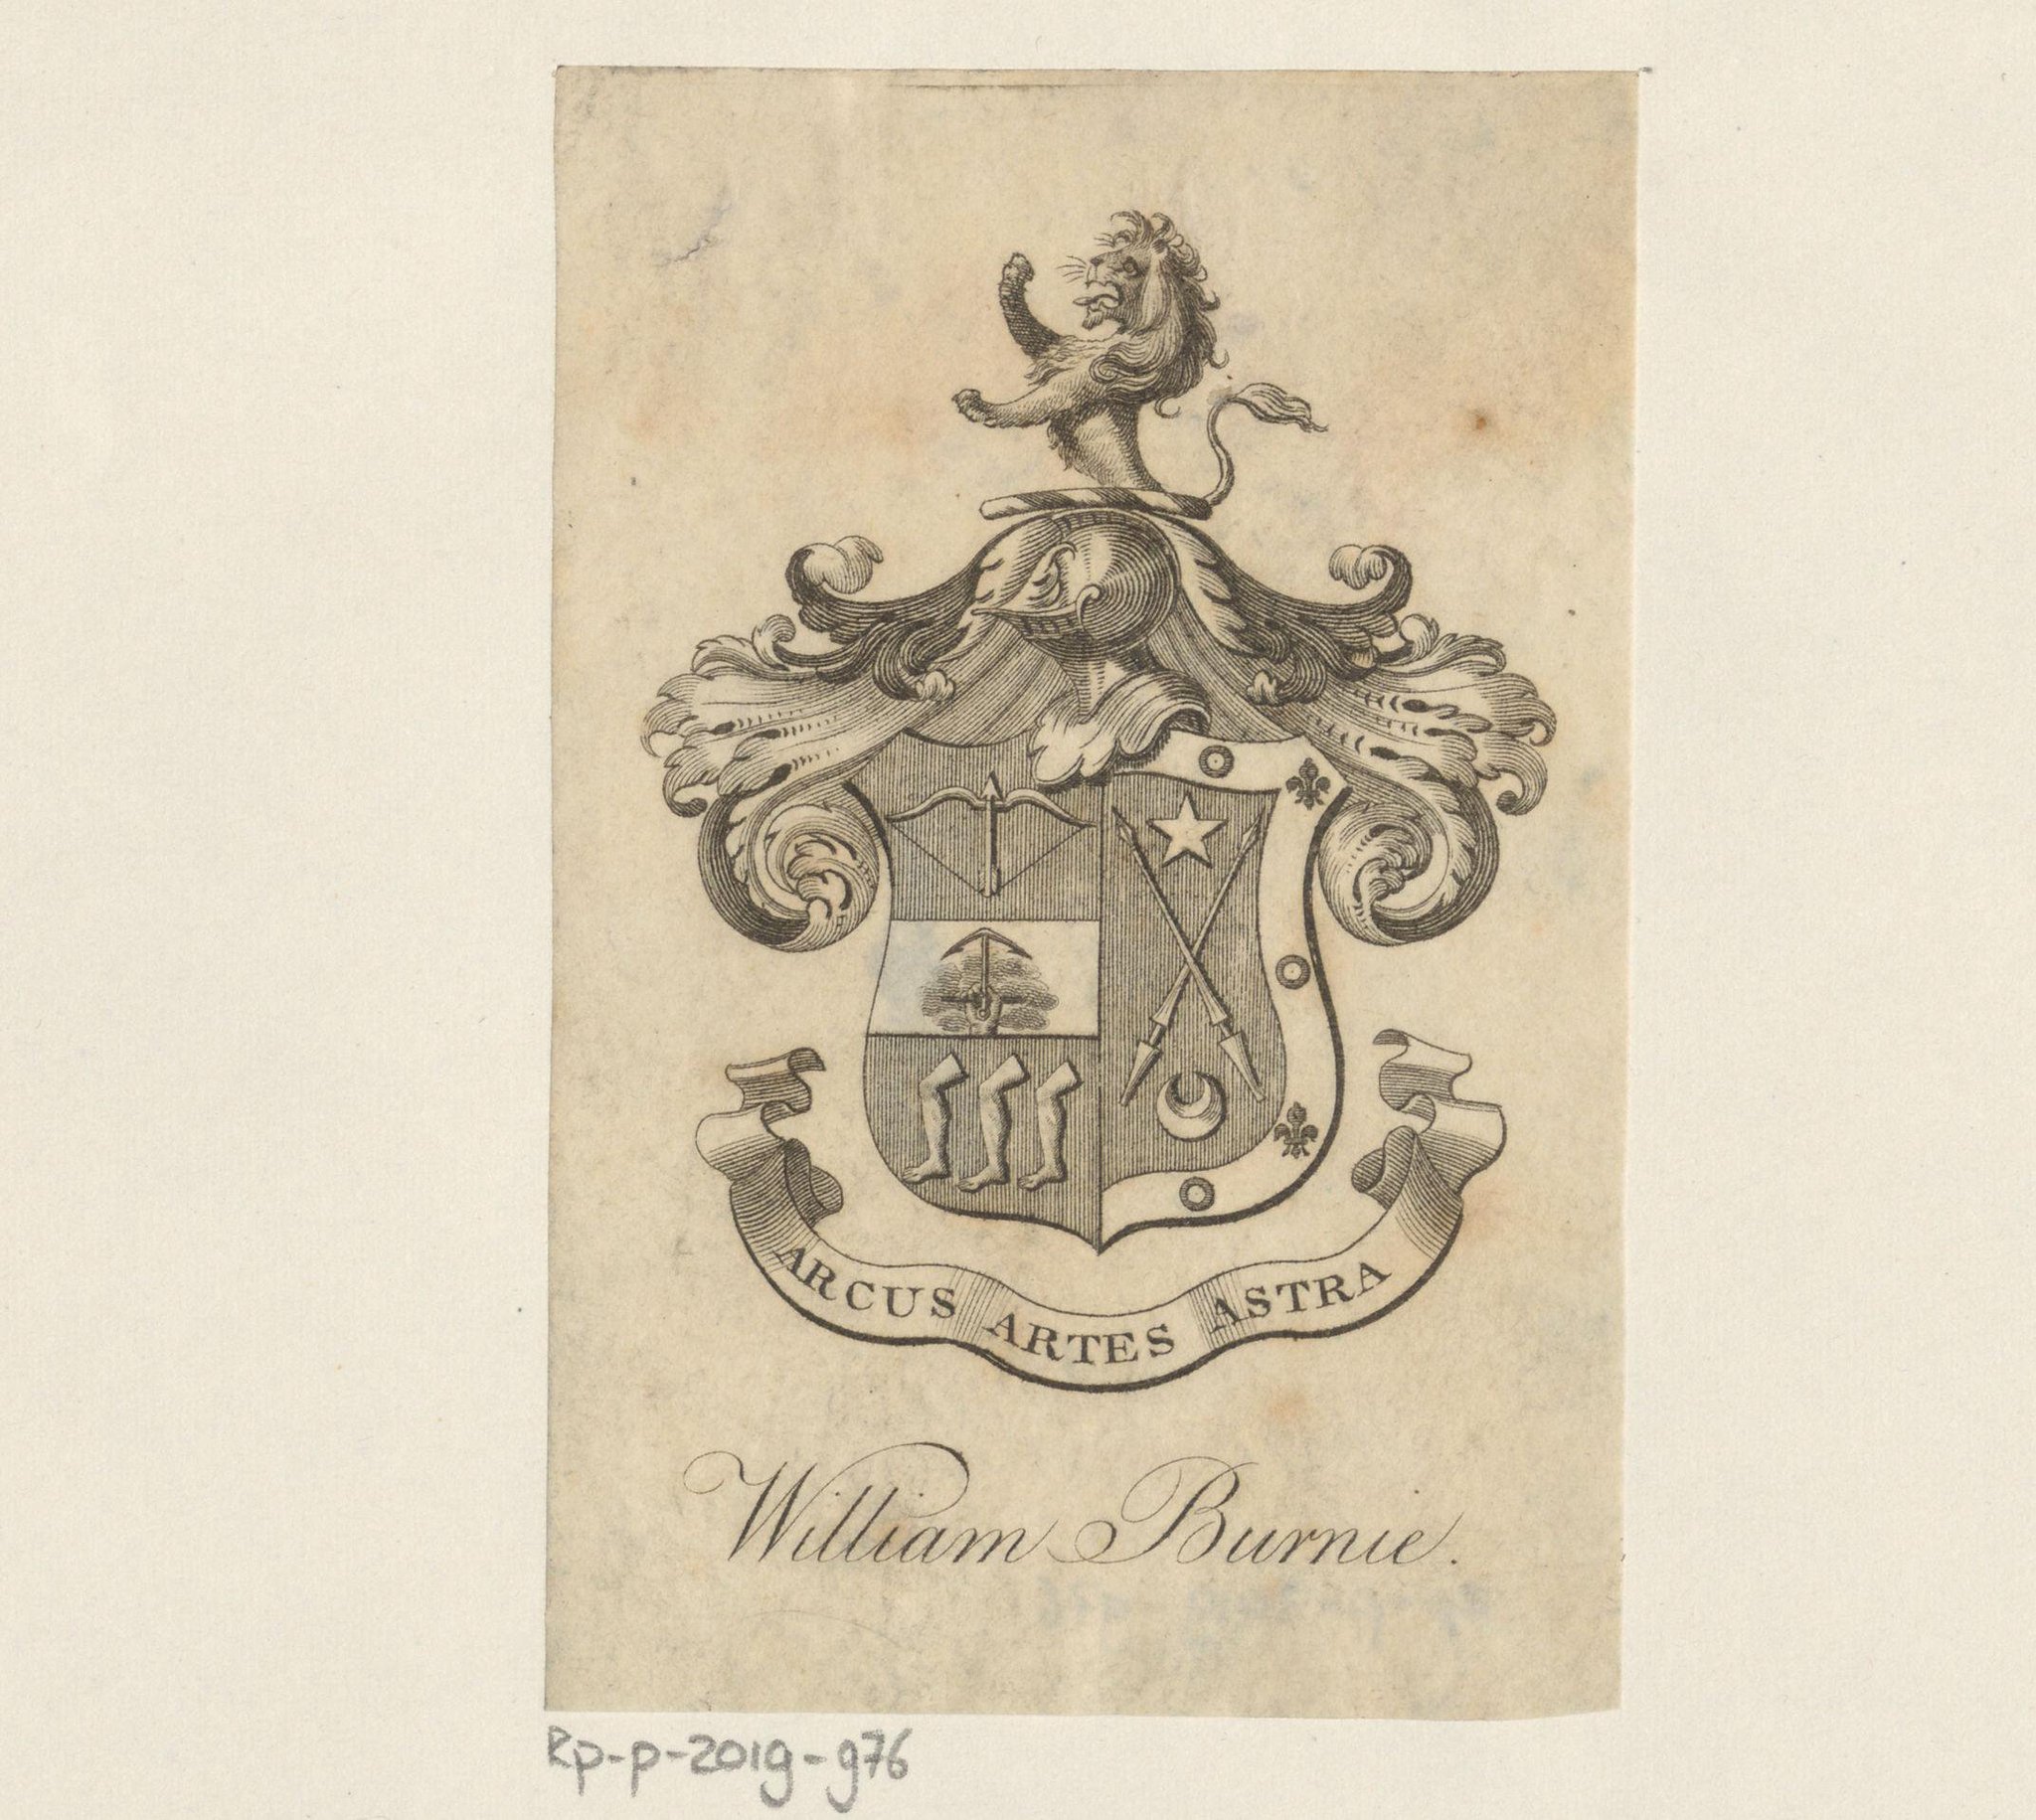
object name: bookplate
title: Arcus artes astra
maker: j. warwick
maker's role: print maker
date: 1750-1849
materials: paper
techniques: engraving, etching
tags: armorial bearing, heraldry